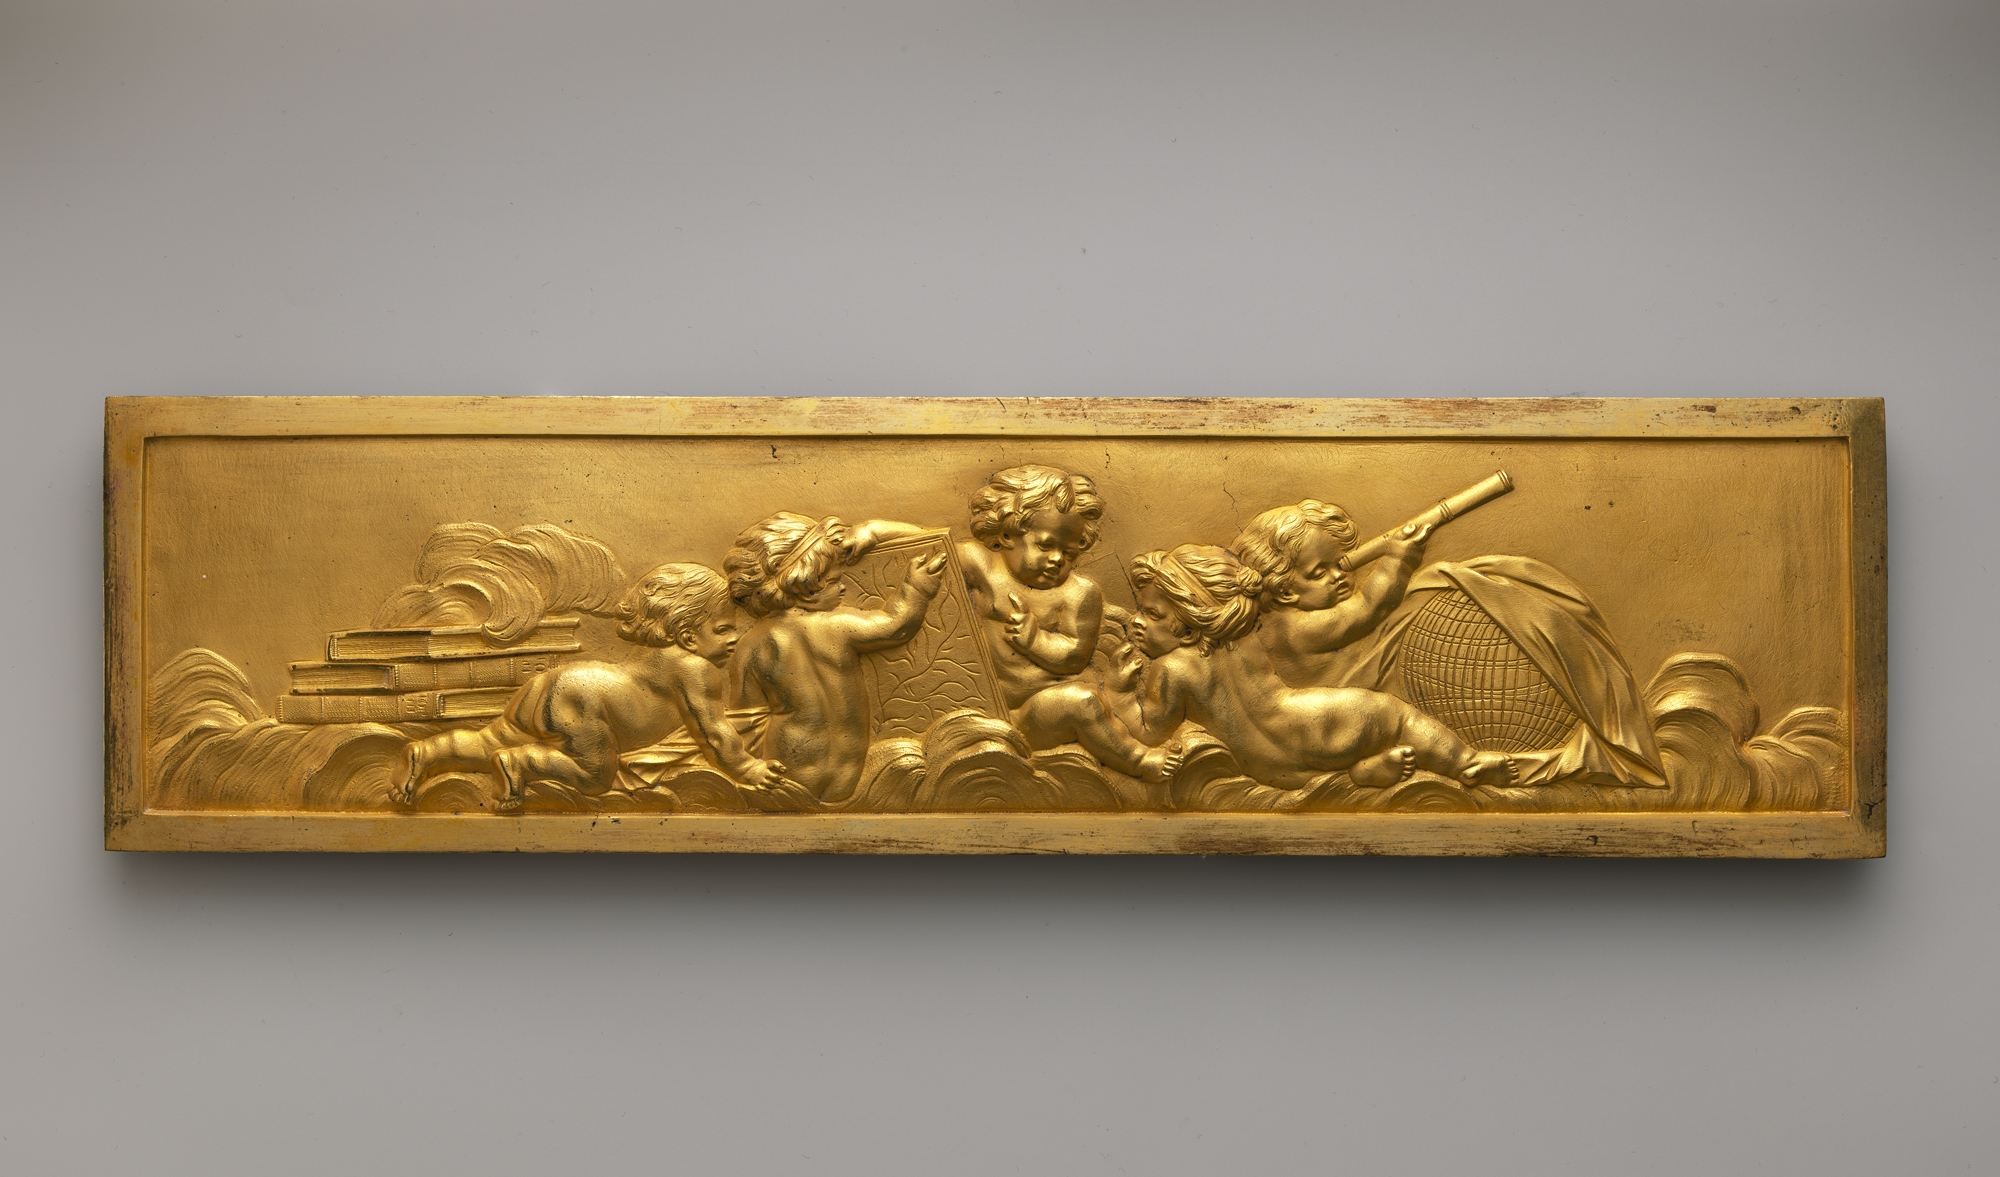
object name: frieze ornament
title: Allegory of Science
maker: françois rémond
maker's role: maker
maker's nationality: french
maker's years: 1747-1812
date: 1785-1790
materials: gilt bronze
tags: children